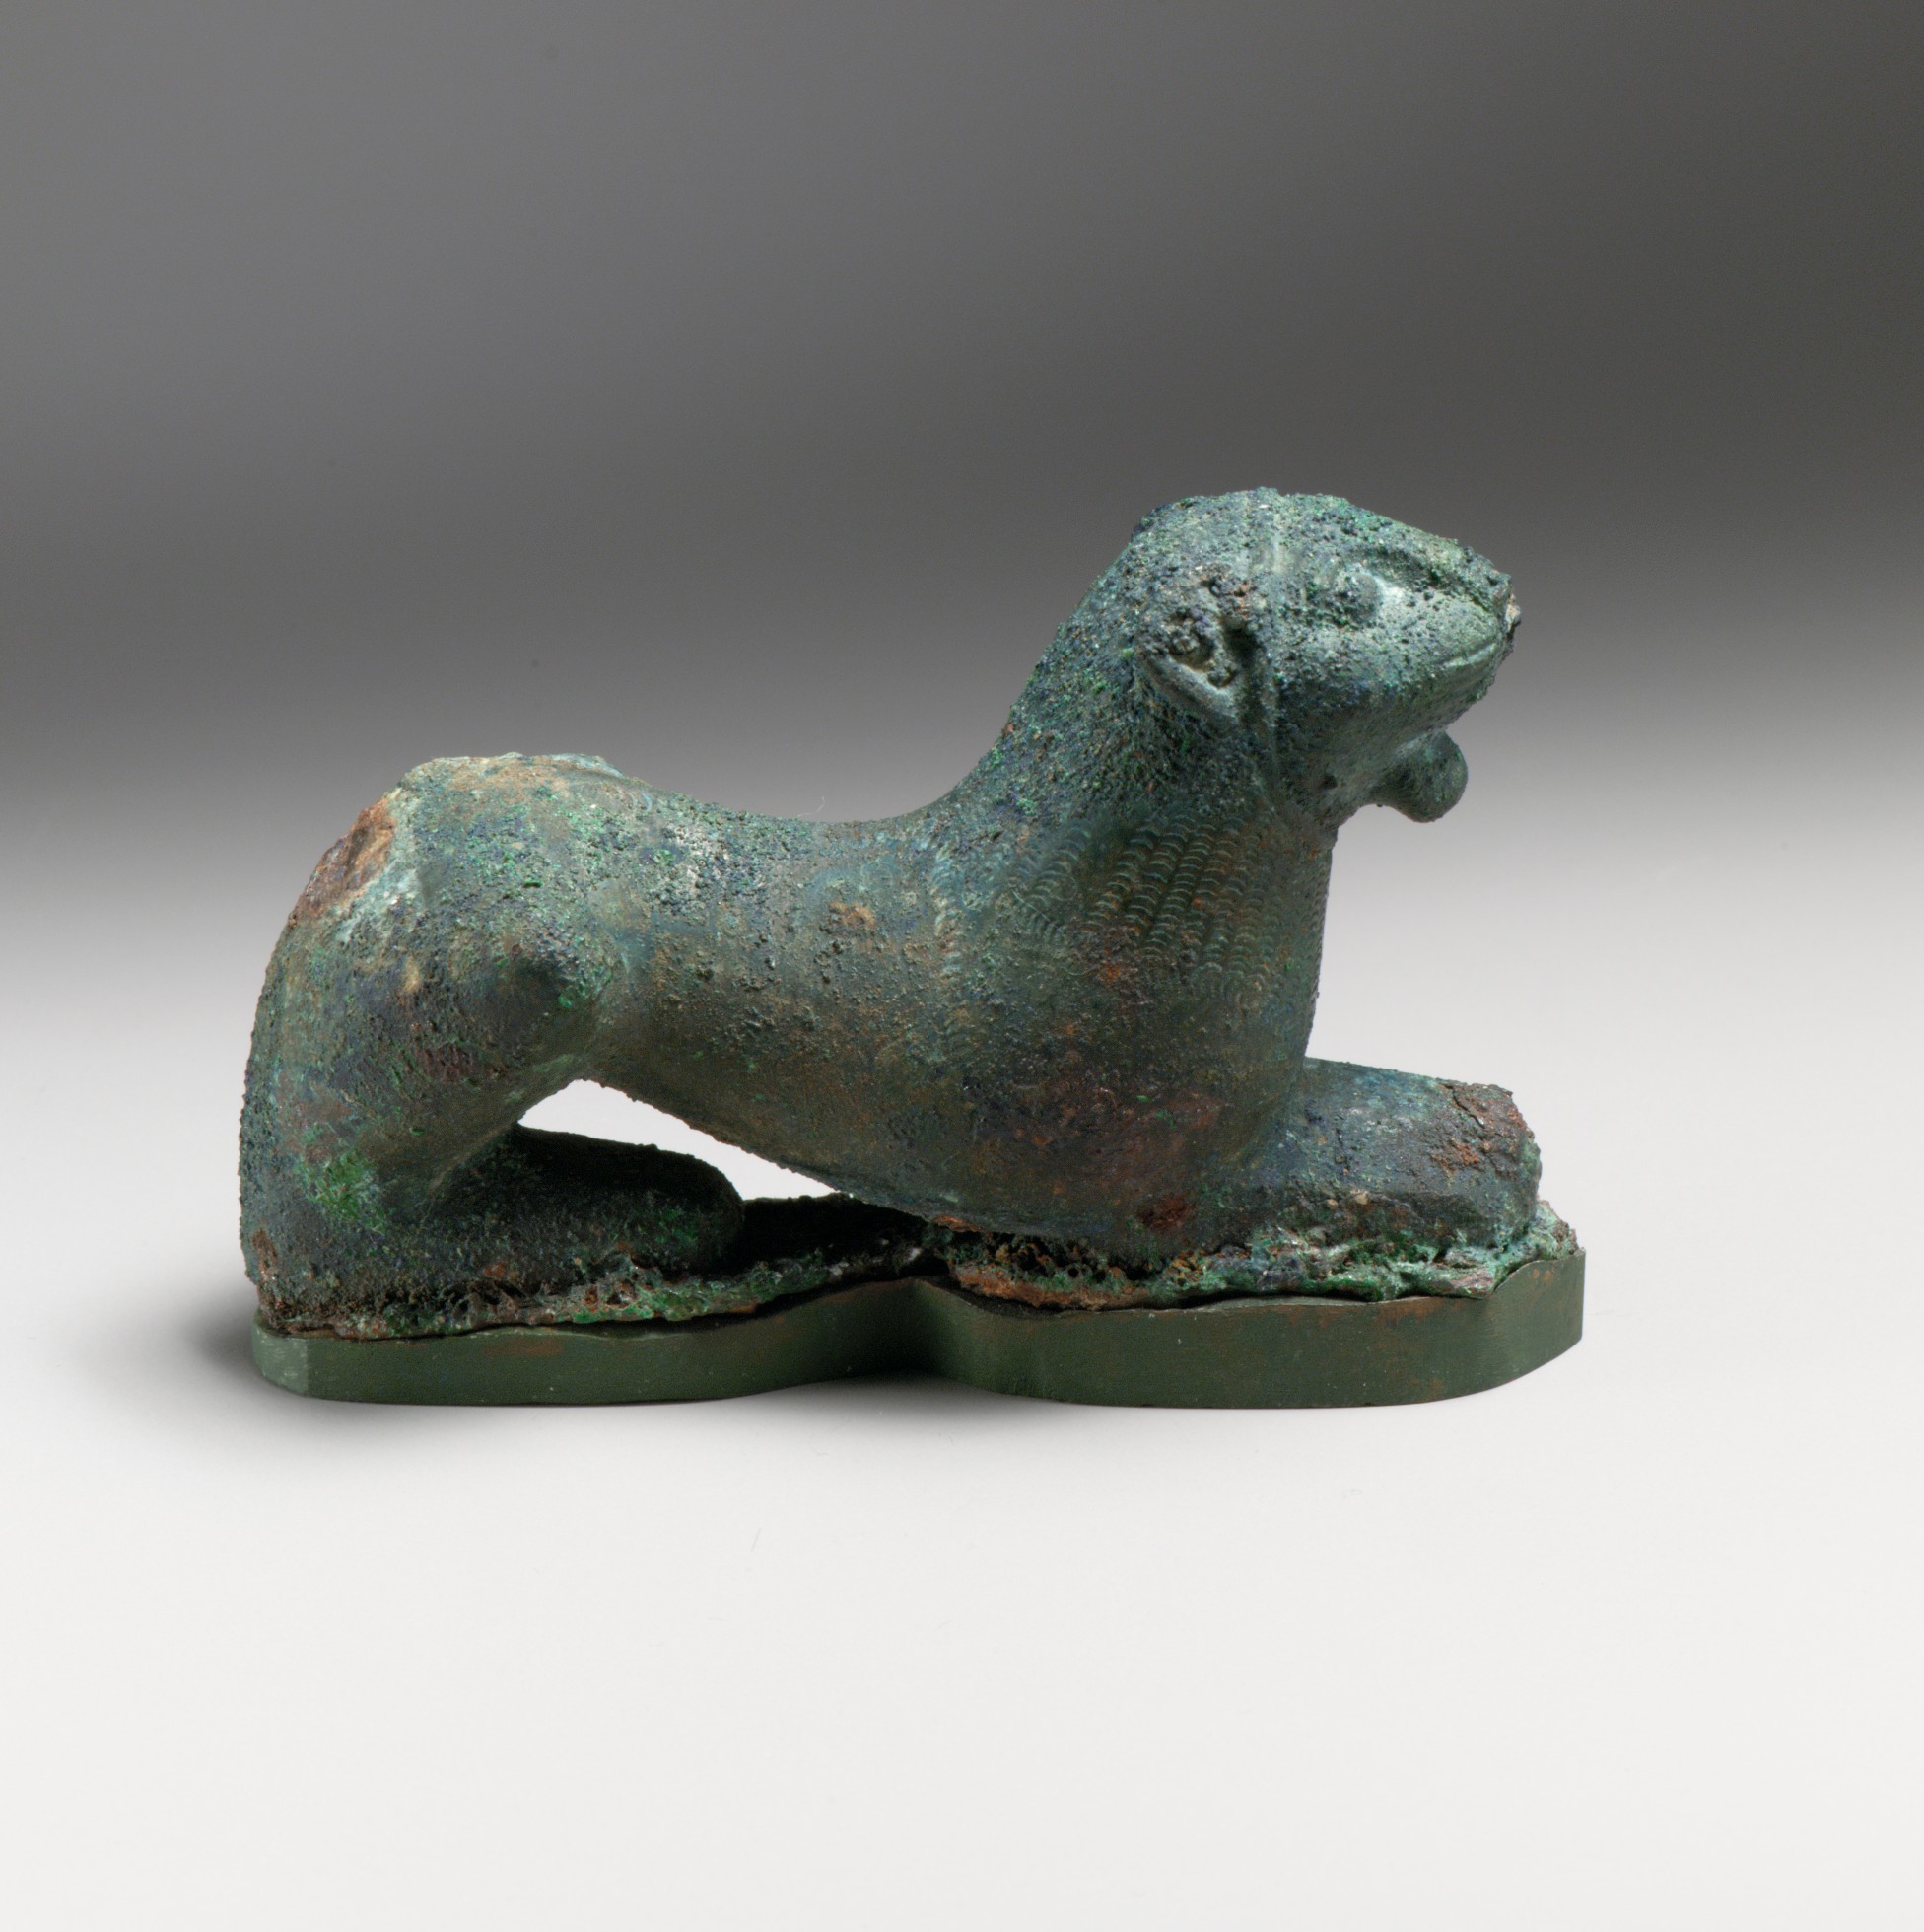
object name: statuette of a lion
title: Pair of bronze statuettes of a lion and a double-headed lion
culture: etruscan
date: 550-500 BCE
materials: bronze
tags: lions